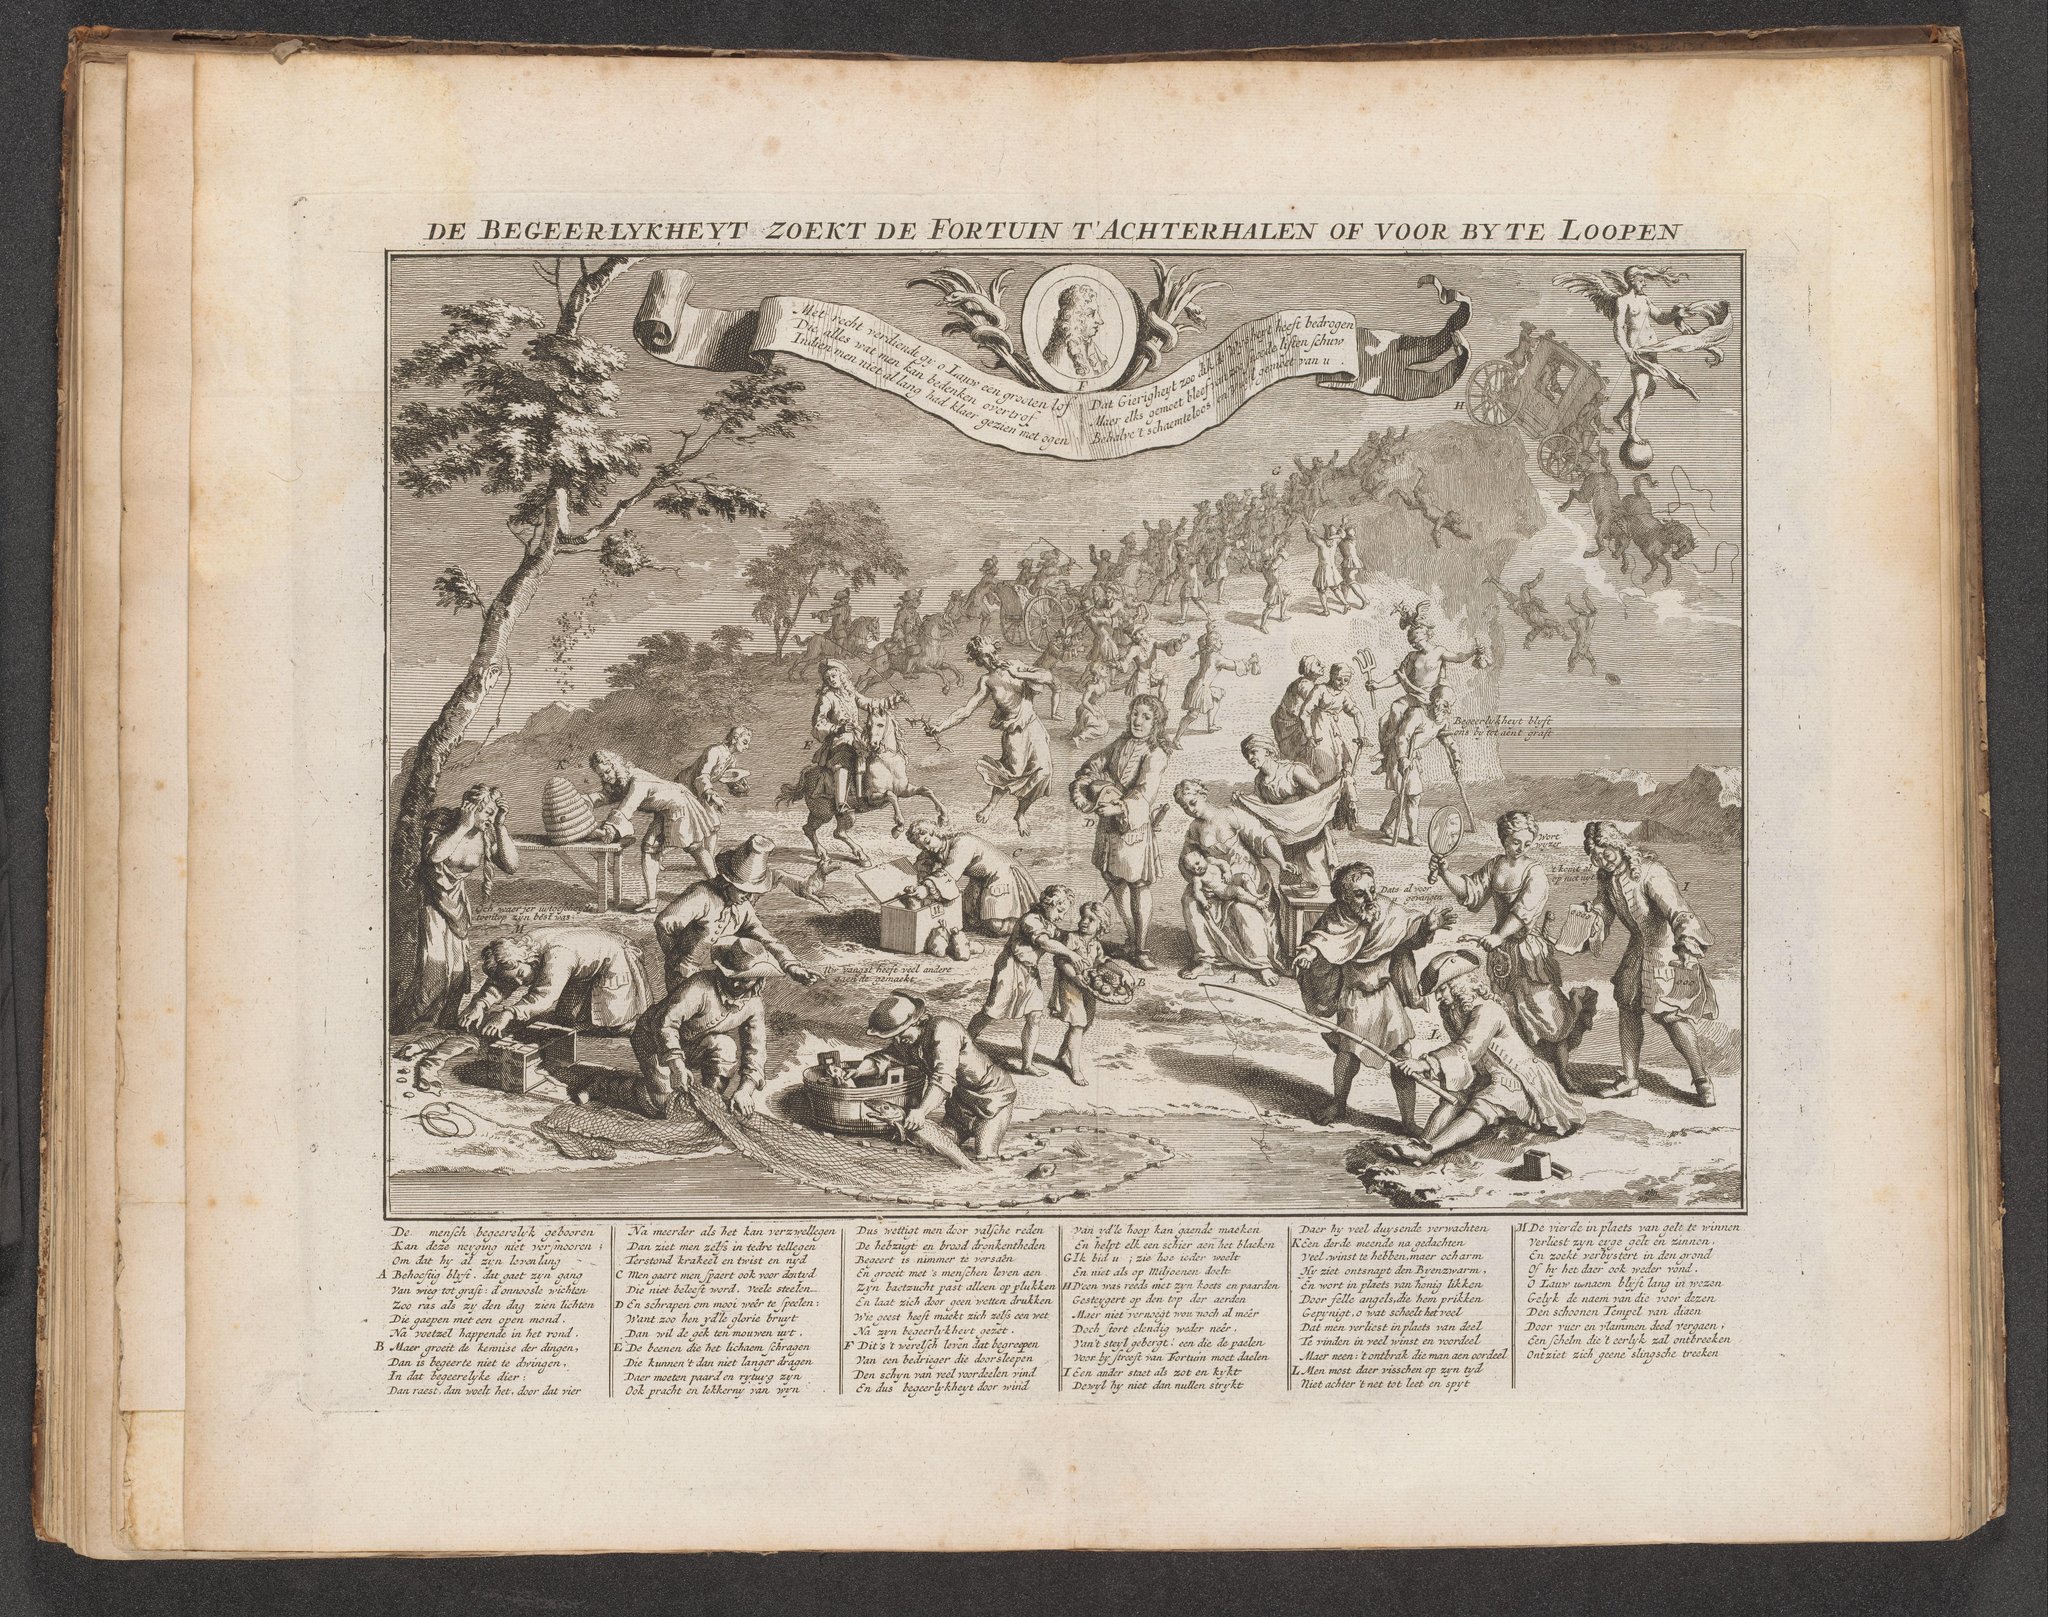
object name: print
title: De Begeerlykheyt zoekt de Fortuin t' achterhalen of voor by te loopen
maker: Anonymous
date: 1720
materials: paper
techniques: engraving, etching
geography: northern netherlands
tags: luck, fortune, lot; 'fato', 'fortuna', 'fortuna aurea', 'fortuna buona', 'fortuna pacifica overo clemente', 'sorte' (ripa)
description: De Hebzucht probeert Fortuna in te halen. Voorstelling van allerlei soorten hebzucht onder de mensen van kinds af aan tot in de ouderdom. Op de achtergrond stort een stoet van windhandelaren te voet en in koetsen zich in achtervolging van Fortuin van een rots in de afgrond. Bovenaan een portret van John Law bij een banderol met zesregelig vers. Met onderschrift in zes kolommen. Prent in de gebonden vierde uitgave (304 B 12) van Het Groote Tafereel der Dwaasheid met spotprenten op de Windhandel of Actiehandel van 1720.